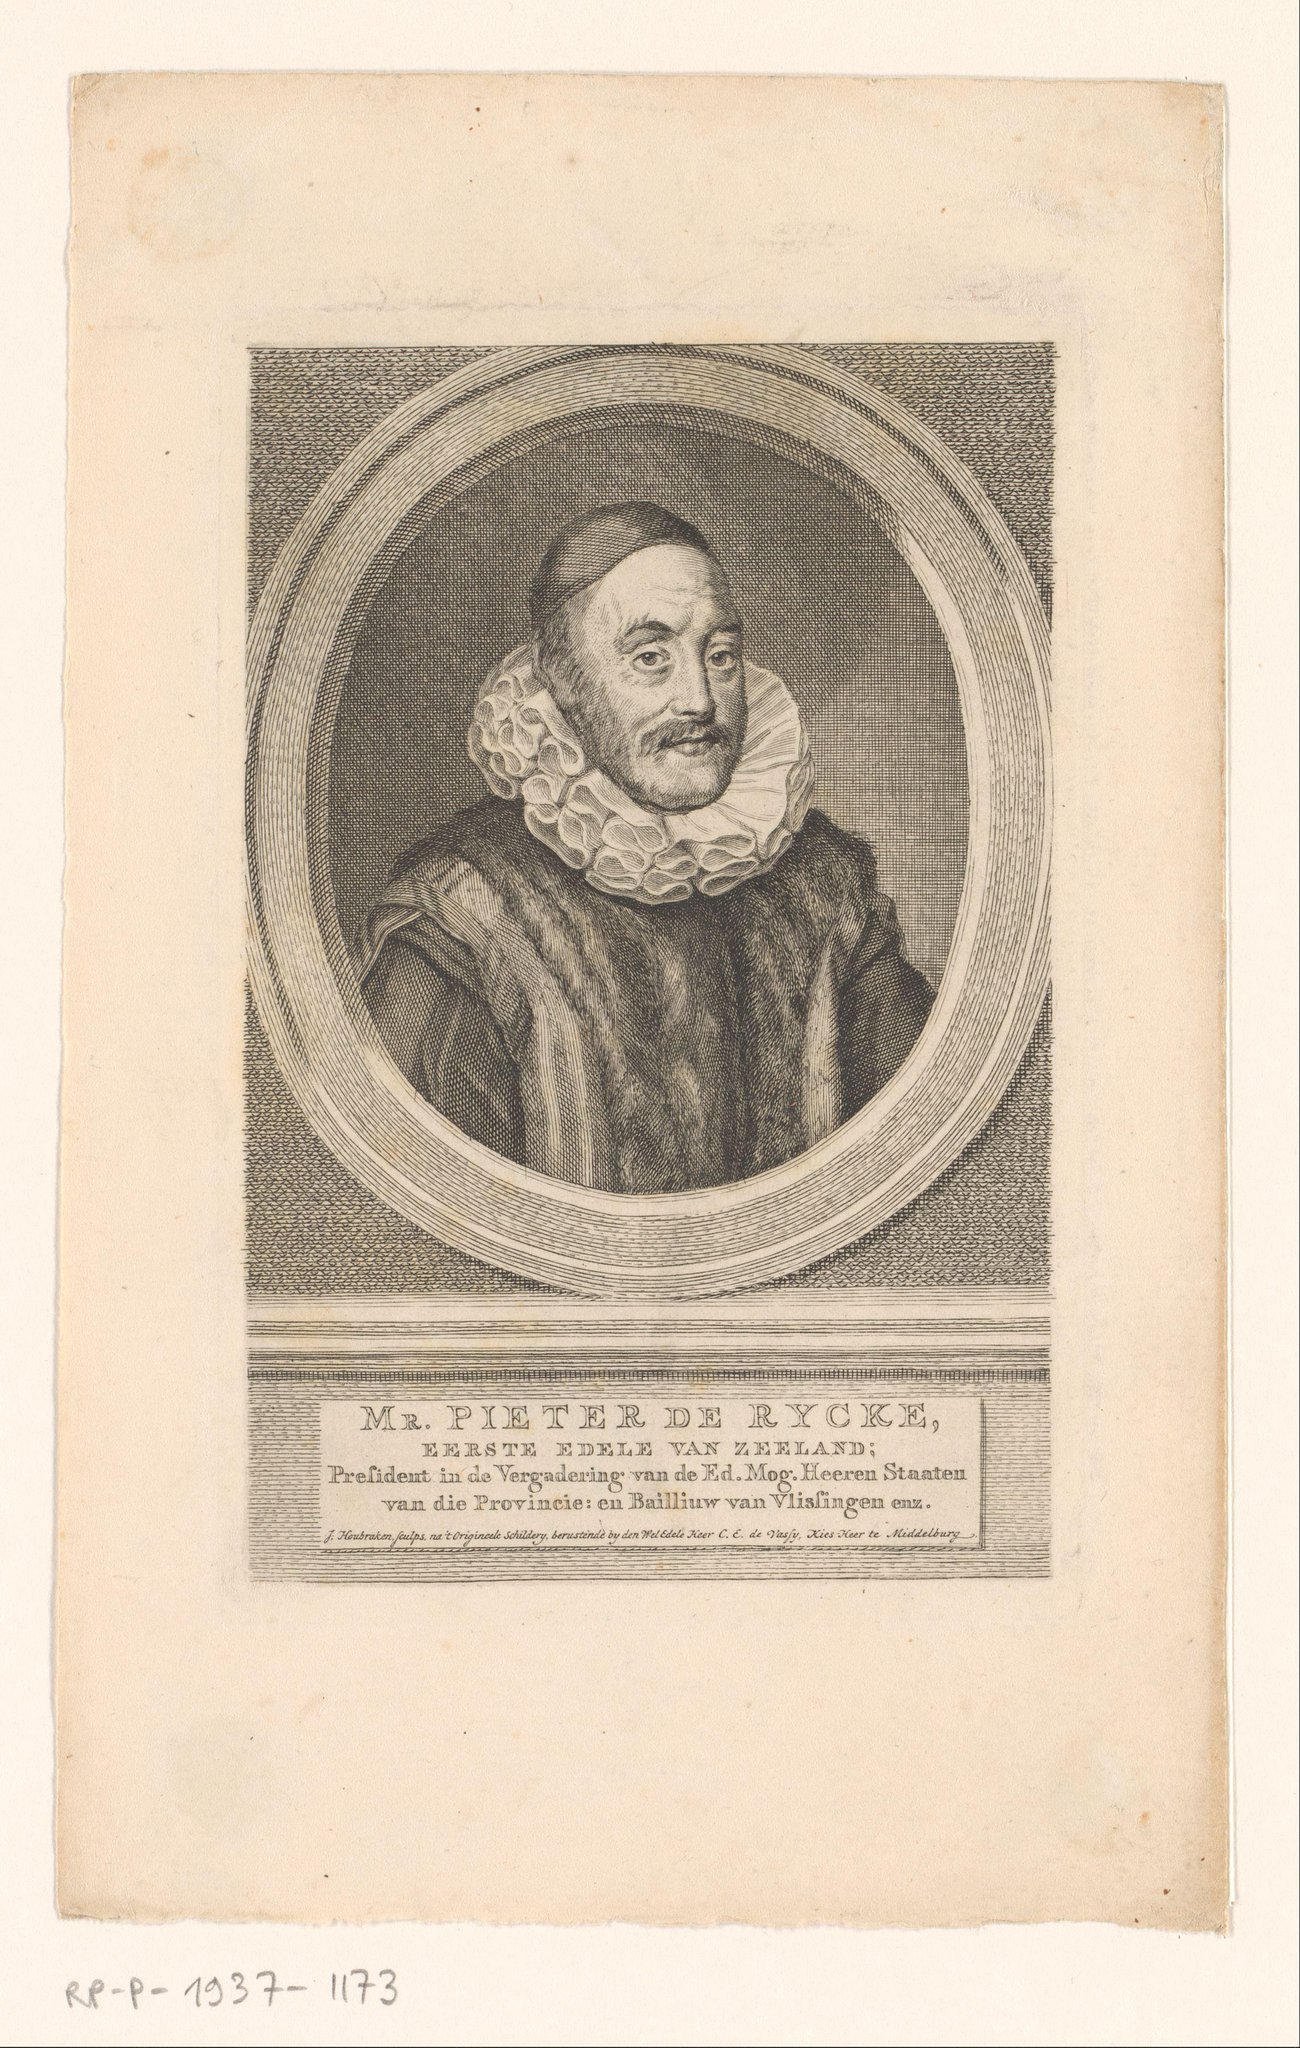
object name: print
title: Portret van Petrus Rijcke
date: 1749-1780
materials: paper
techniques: engraving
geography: amsterdam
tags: ornament ~ medallion, historical persons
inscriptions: collector's mark: Lugt 2228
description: Deze prent is oorspronkelijk bedoeld als aanvulling op Jan Wagenaars ‘Vaderlandsche historie’* en was zo vanaf 1796 verkrijgbaar bij Johannes Allart te Amsterdam. Voor de advertentie waarin Allart de 60 portretten en 7 platen, allen gegraveerd door Houbraken, ter aanvulling op Wagenaars ‘Vaderlandsche historie’ aanbiedt, zie RP-P-OB-77.766. *Van dit werk zijn in de achttiende eeuw meerdere uitgaves verschenen, zoals: Wagenaar, Jan. Vaderlandsche historie, vervattende de geschiedenissen der Vereenigde Nederlanden (…). 21 delen. Amsterdam: Isaak Tirion, 1749-1759. Wagenaar, Jan. Vaderlandsche historie, vervattende de geschiedenissen der nu Vereenigde Nederlanden (…). 21 delen. Amsterdam: weduwe Isaak Tirion, 1770. Wagenaar, Jan. Vaderlandsche historie, vervattende de geschiedenissen der nu Vereenigde Nederlanden (…). 21 delen. Amsterdam, Leiden, Dordrecht en Harlingen: P. Schouten e.a., 1782. Wagenaar, Jan. Vaderlandsche historie, vervattende de geschiedenissen der nu Vereenigde Nederlanden (…). 21 delen. Amsterdam: Johannes Allart, 1790-1796.